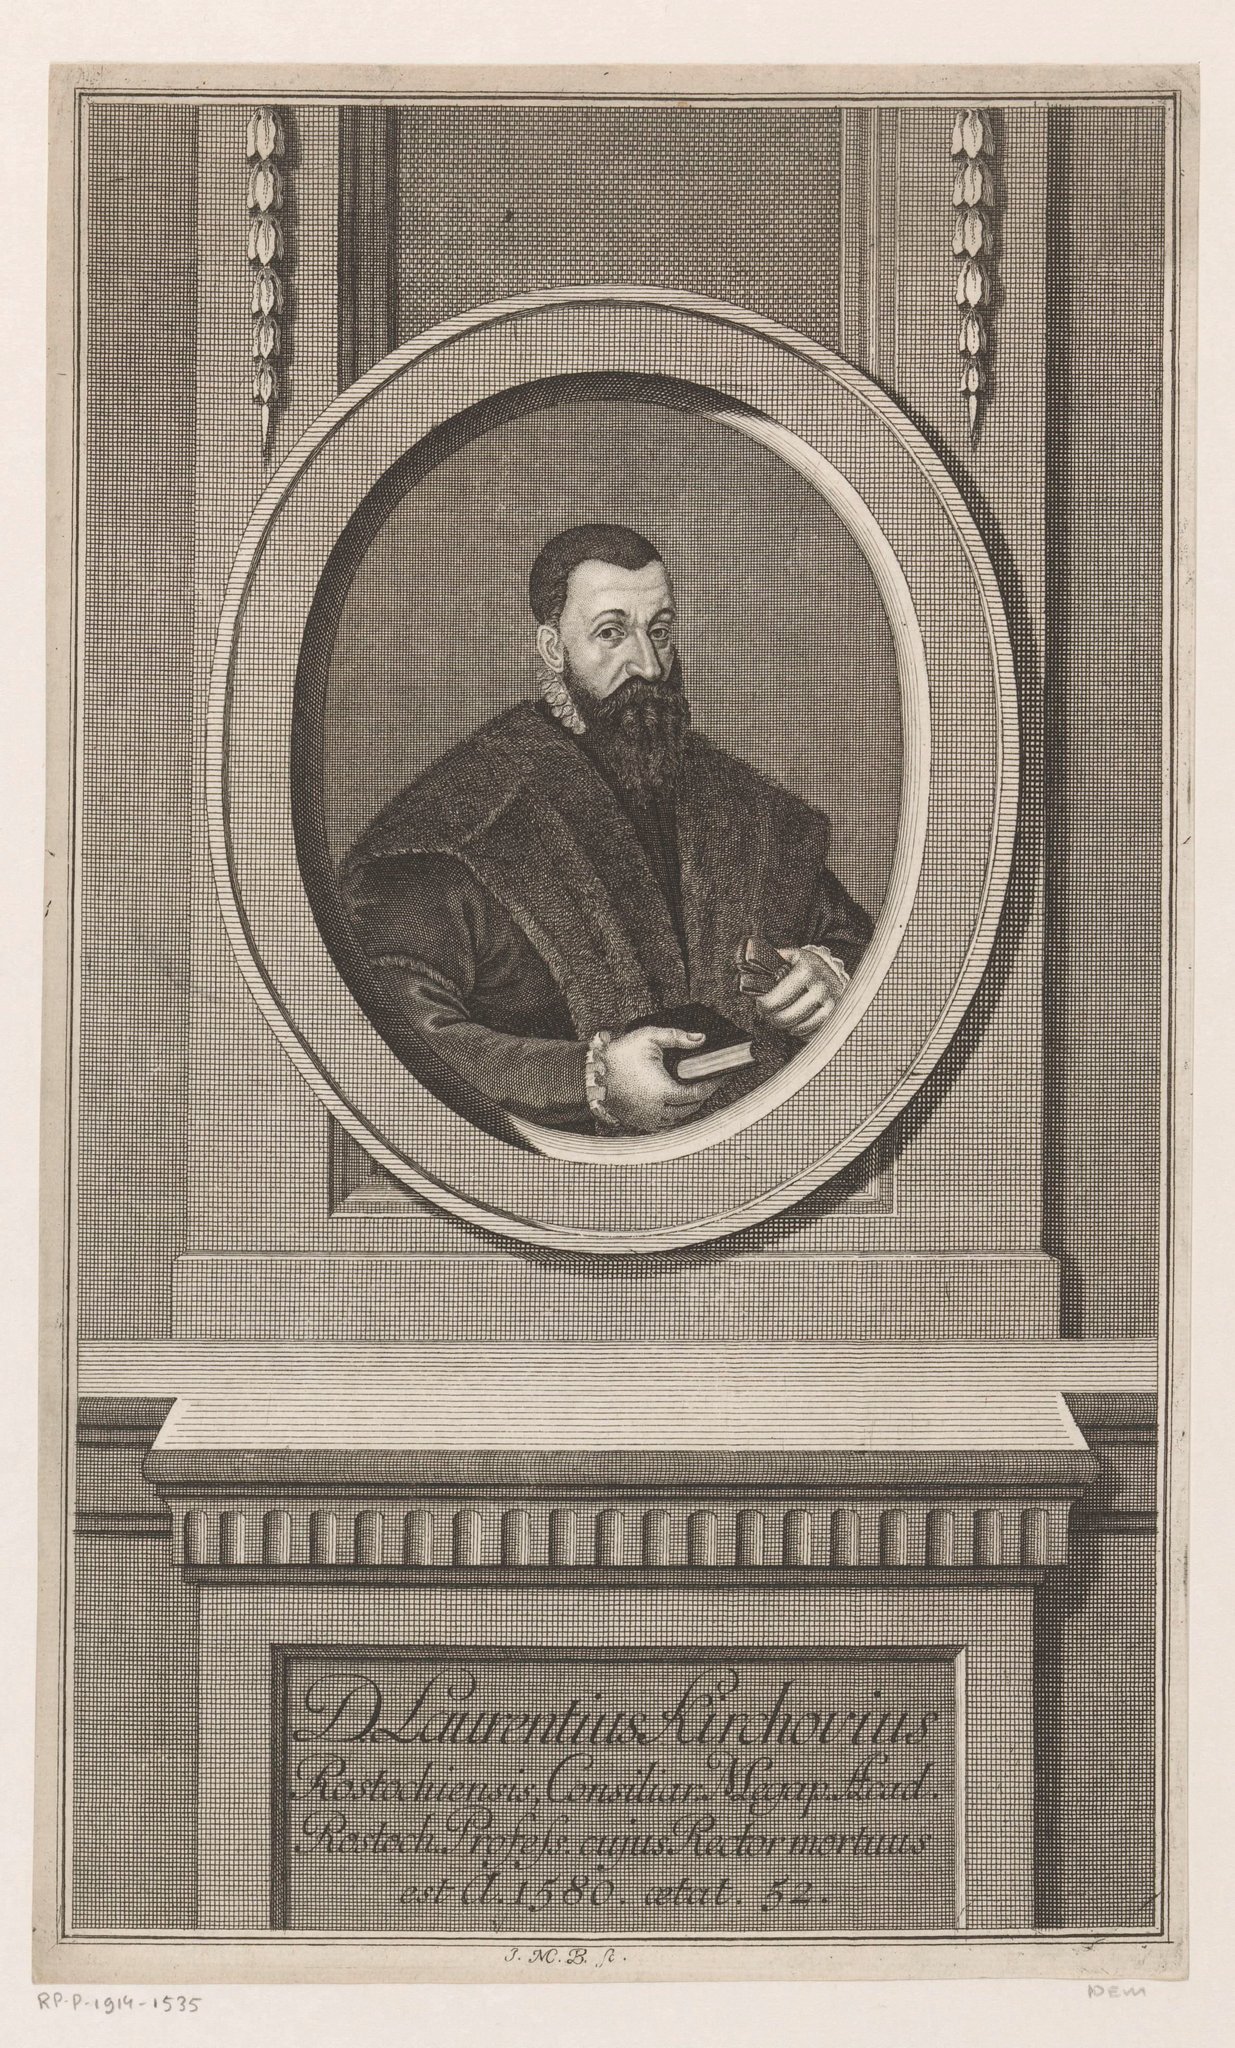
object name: print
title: Portret van Laurentius Kirchhoff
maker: johann martin bernigeroth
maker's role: print maker, publisher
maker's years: 1713-1767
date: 1743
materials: paper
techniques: engraving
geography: leipzig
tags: historical persons, book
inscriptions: collector's mark: Lugt 2228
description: Een andere staat van deze prent is gebruikt in: Westphalen, Ernst Joachim von. Monumenta Inedita Rerum Germanicarum Praecipue Cimbricarum Et Megapolensium (...). 4 dln. Leipzig: Johann Christian Martini, 1739-1745, dl. 3 (1743), p. 1340.